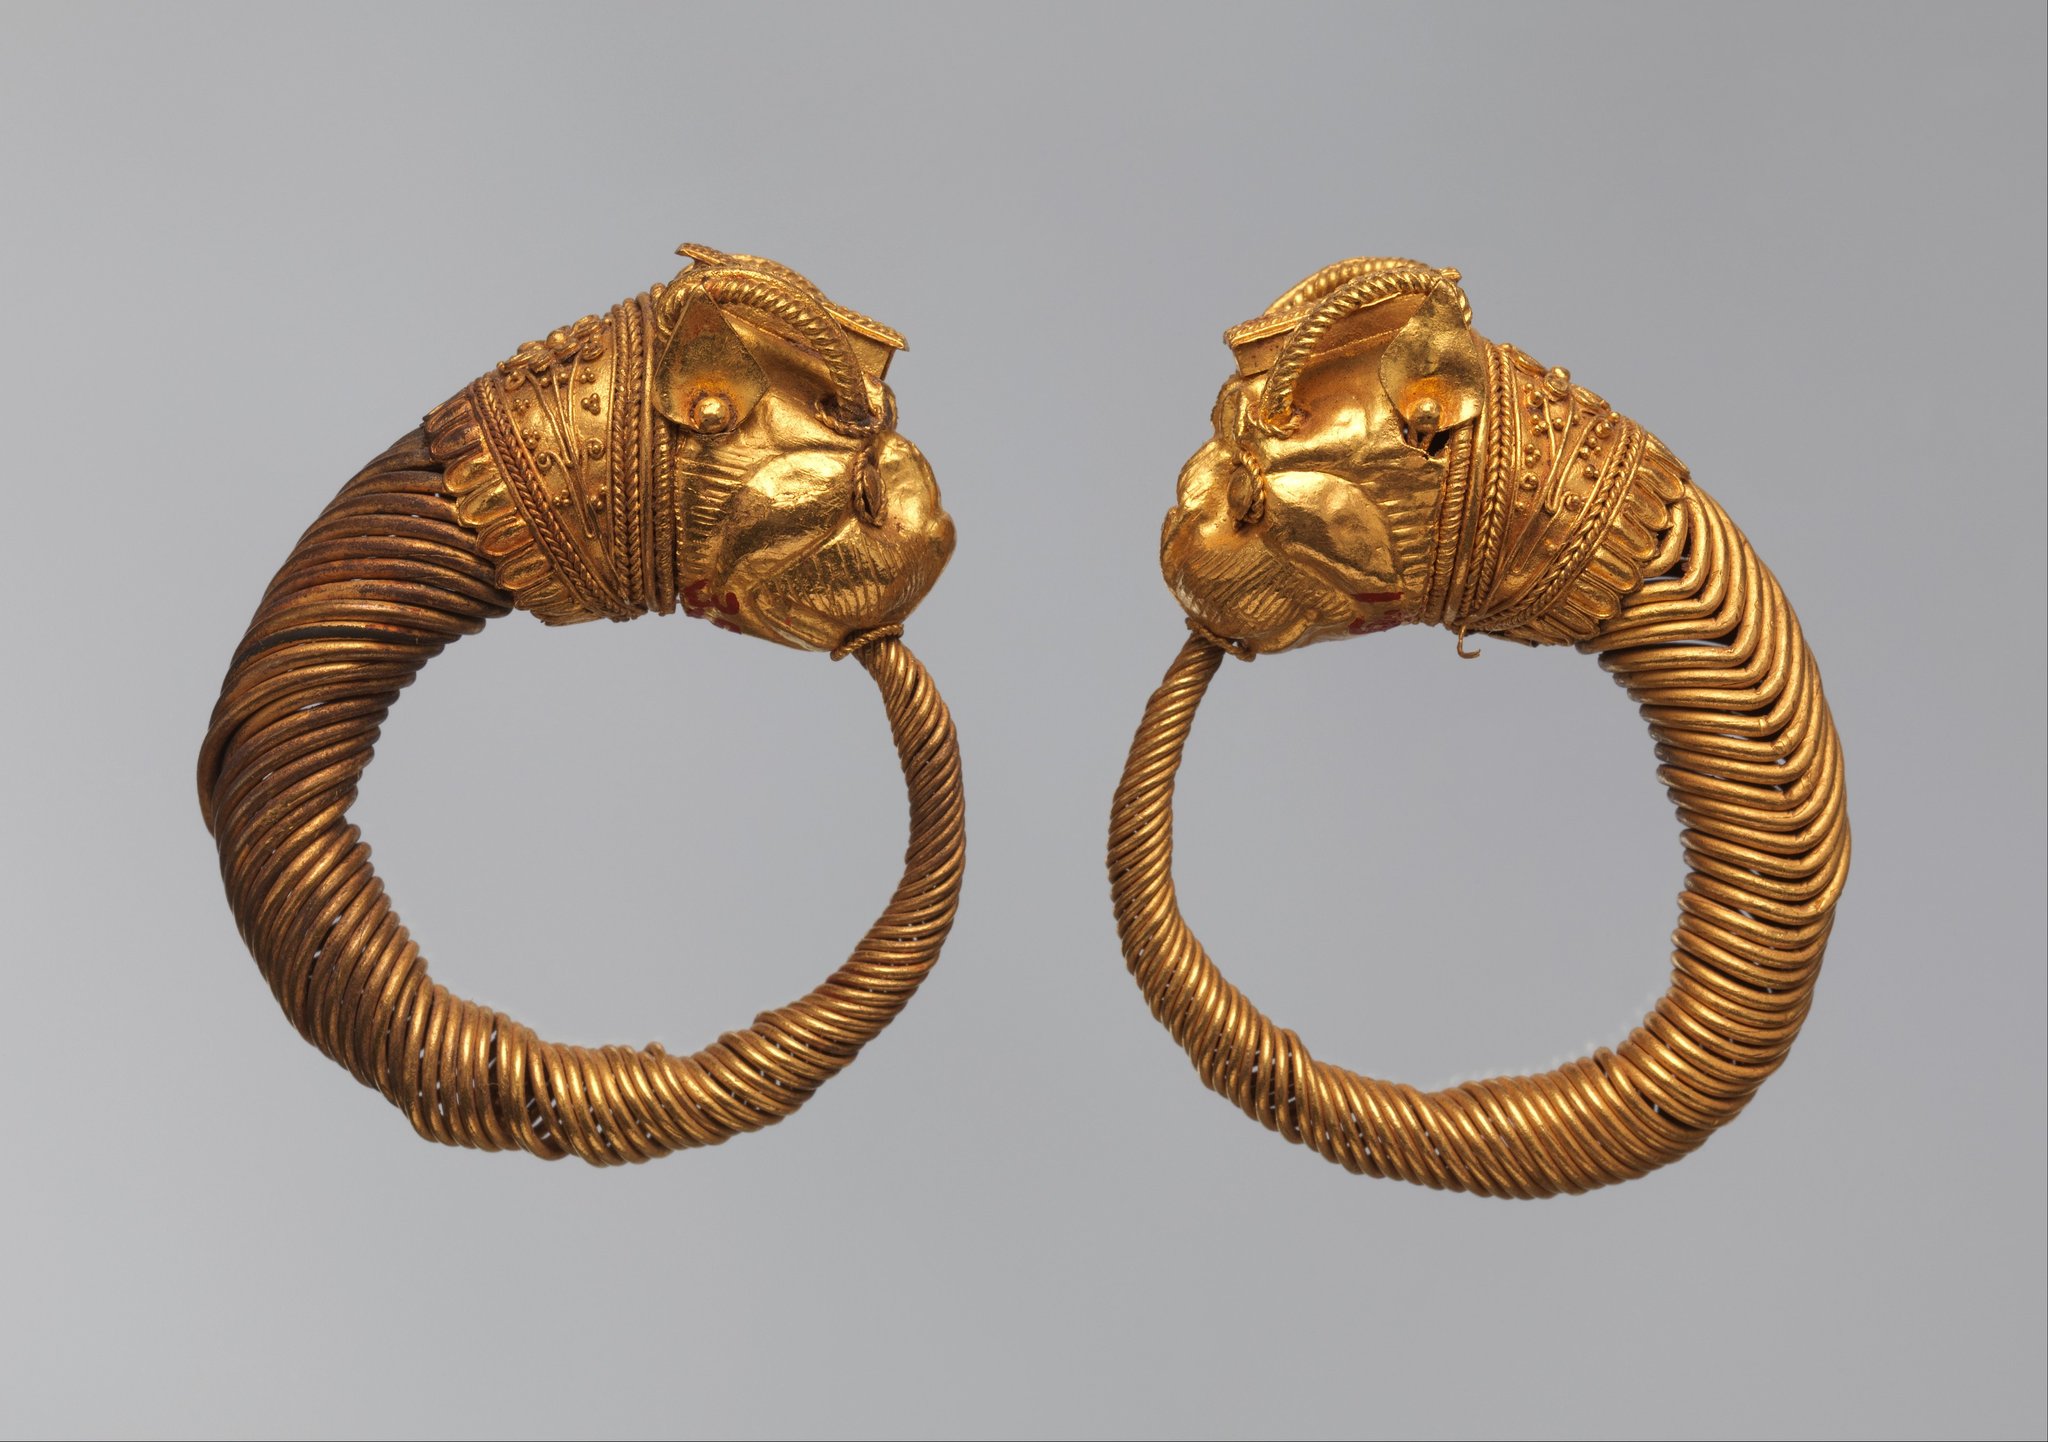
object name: earring, head of lion griffin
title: Earring with head of lion-griffin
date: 400-201 BCE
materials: gold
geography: egypt